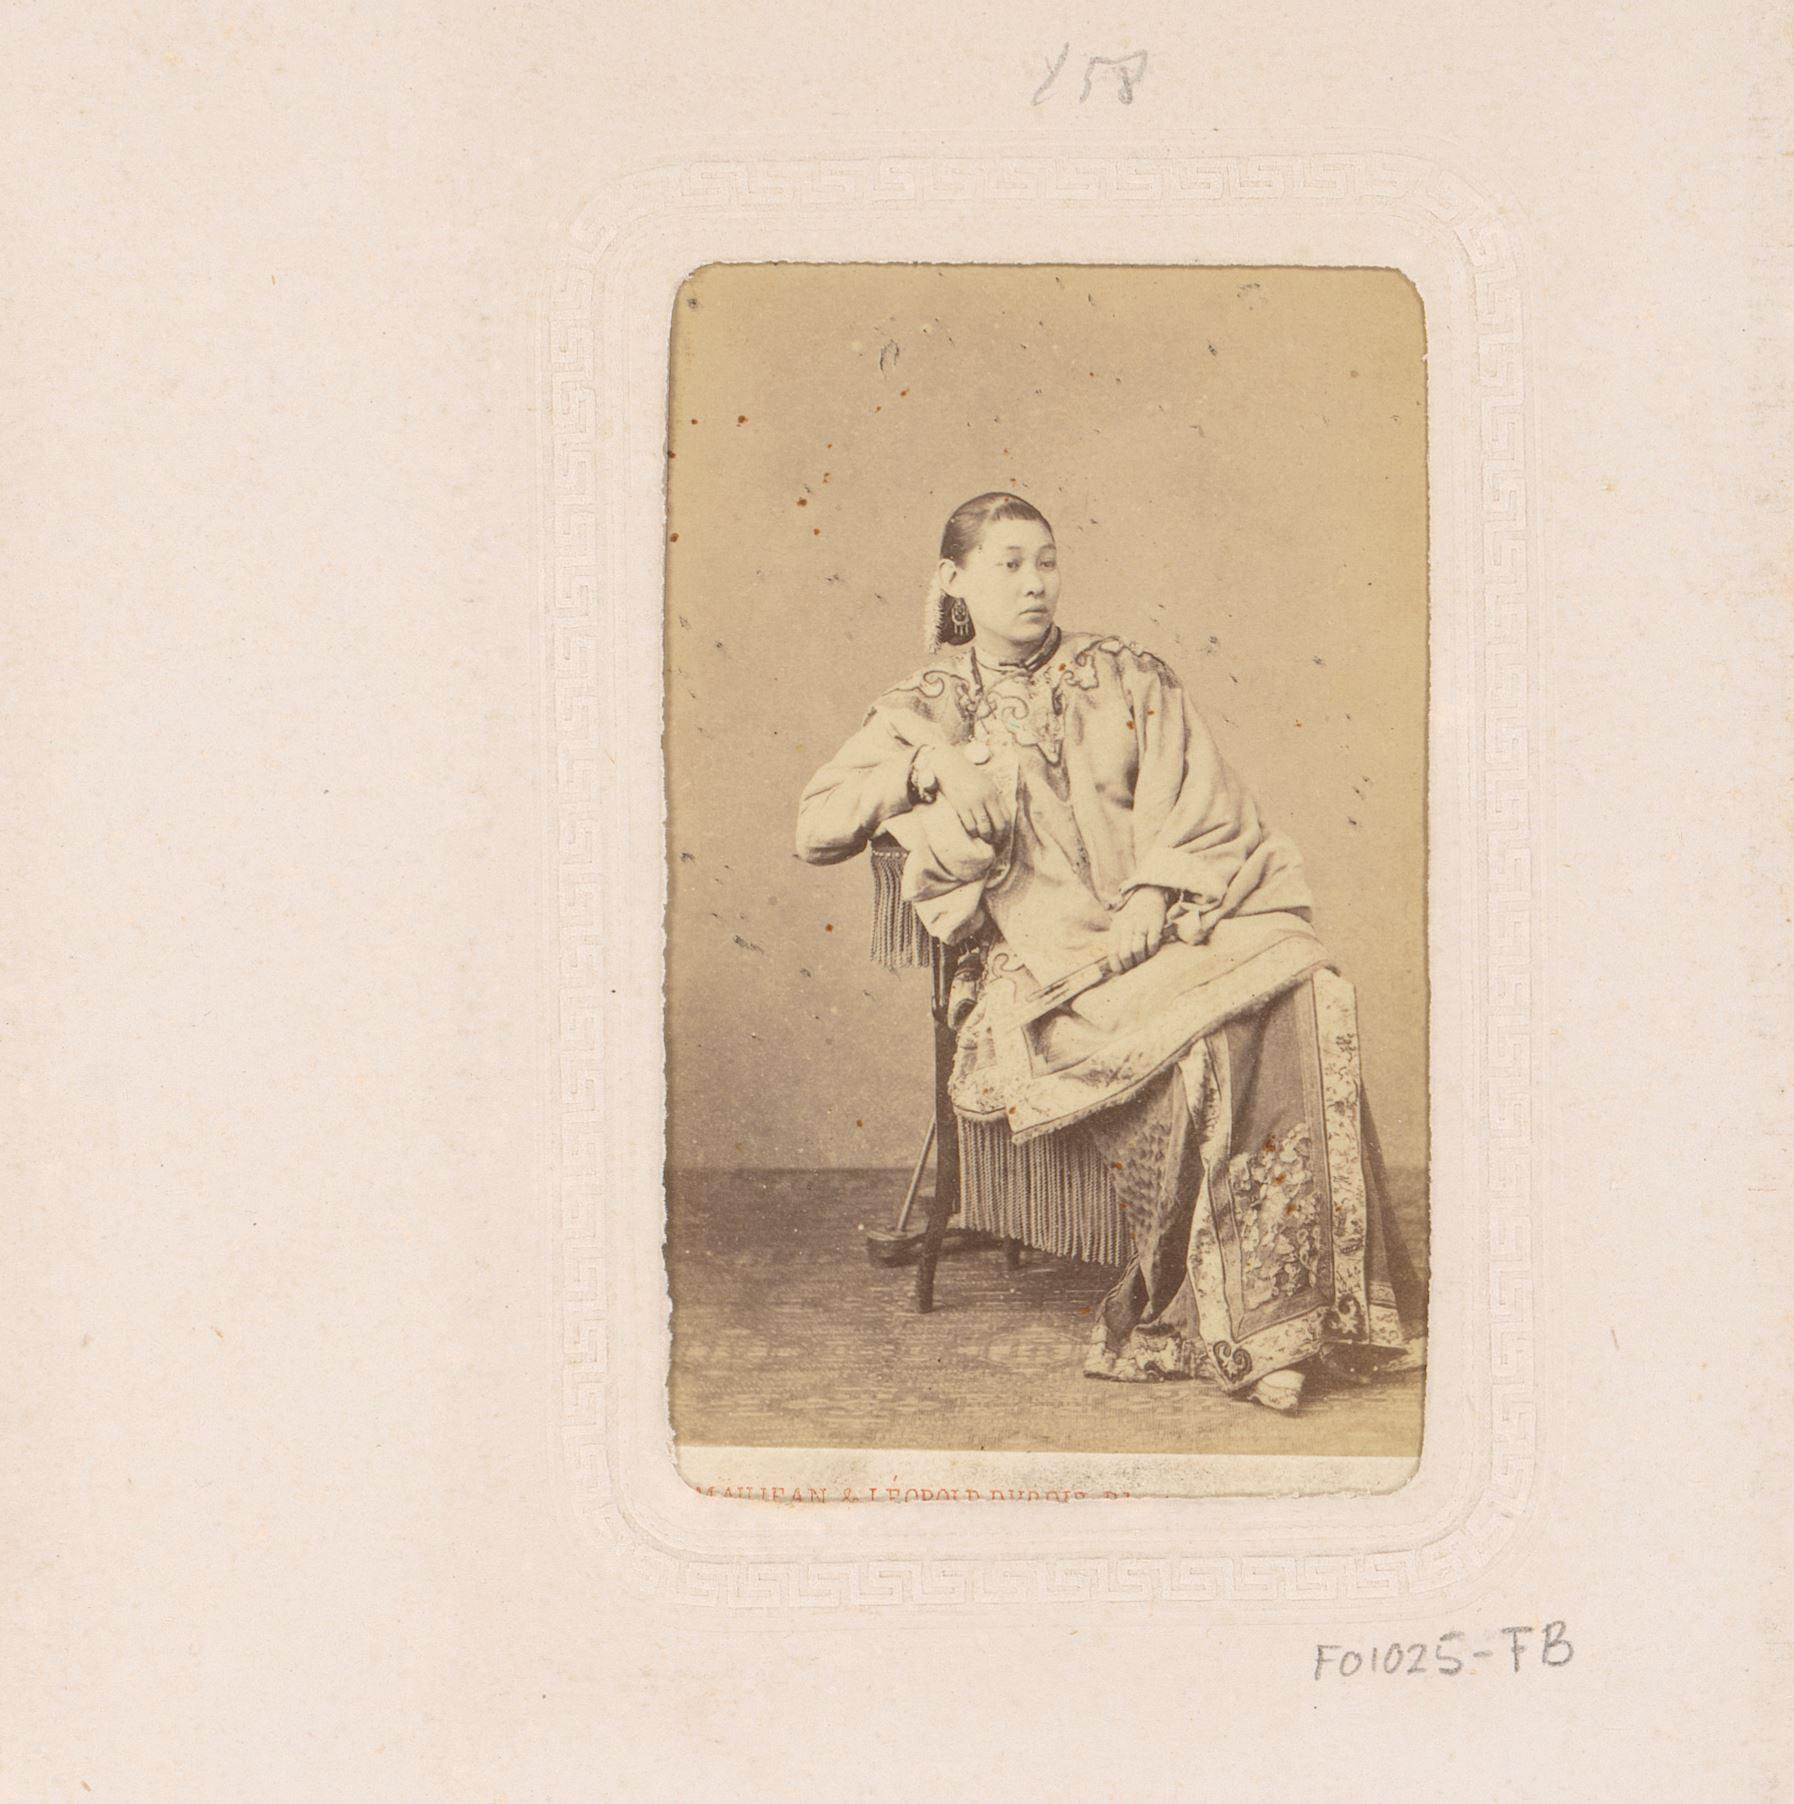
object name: album leaf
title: Portret van een zittende Chinese vrouw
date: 1850-1880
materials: cardboard, photographic support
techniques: albumen print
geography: paris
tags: sitting figure - aa - female human figure, historical persons - bb - woman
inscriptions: inscription: ‘Photographie Maujean et Léopold Dubois/ 30, Rue du Faubourg St. Honore (...) Paris’, annotation: ‘[...]’, number: ‘158’